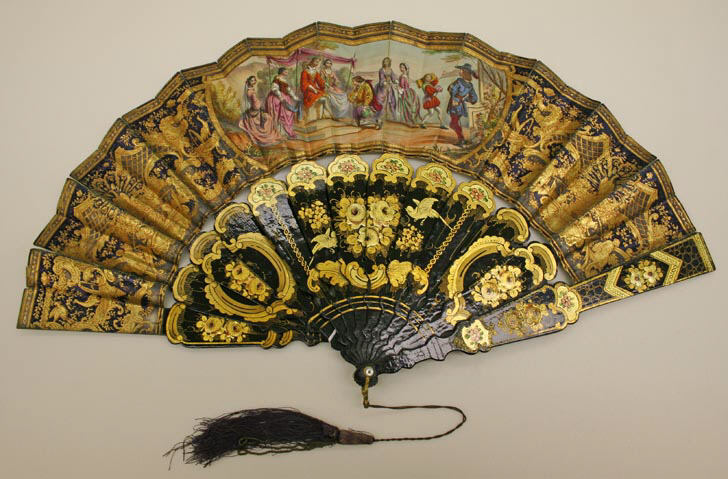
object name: fan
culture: french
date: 1875-1890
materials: paper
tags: men,women,flowers